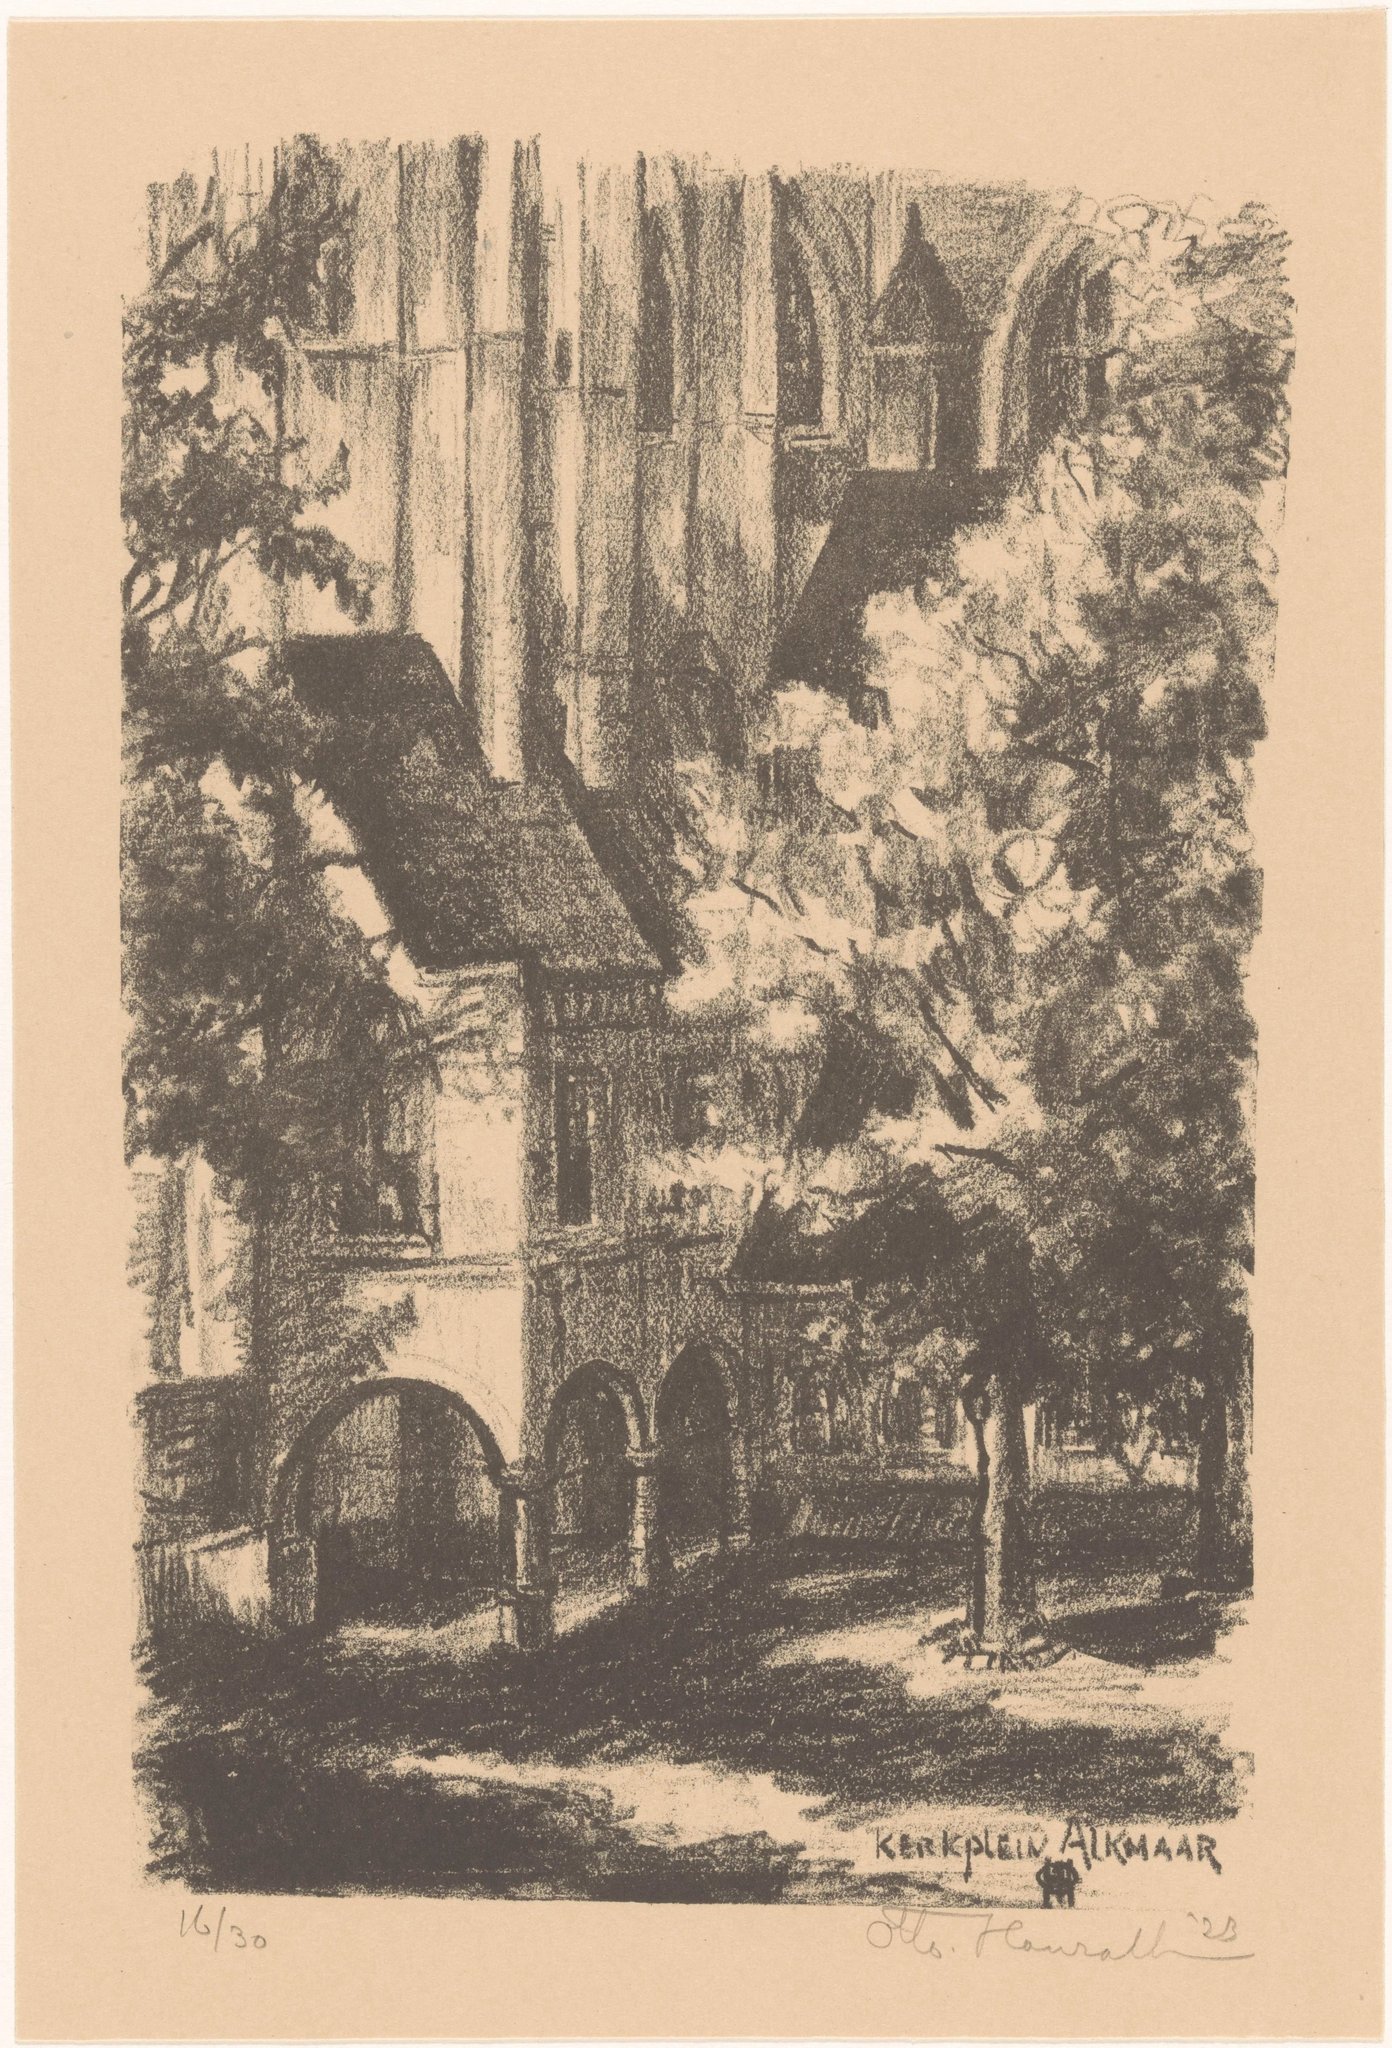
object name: print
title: Kerkplein, Alkmaar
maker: otto hanrath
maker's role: print maker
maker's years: 1882-1944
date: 1923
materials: paper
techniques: lithograph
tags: church (exterior), village square, place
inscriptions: collector's mark: Lugt 2228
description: De Grote of Sint-Laurenskerk aan het Kerkplein in Alkmaar.